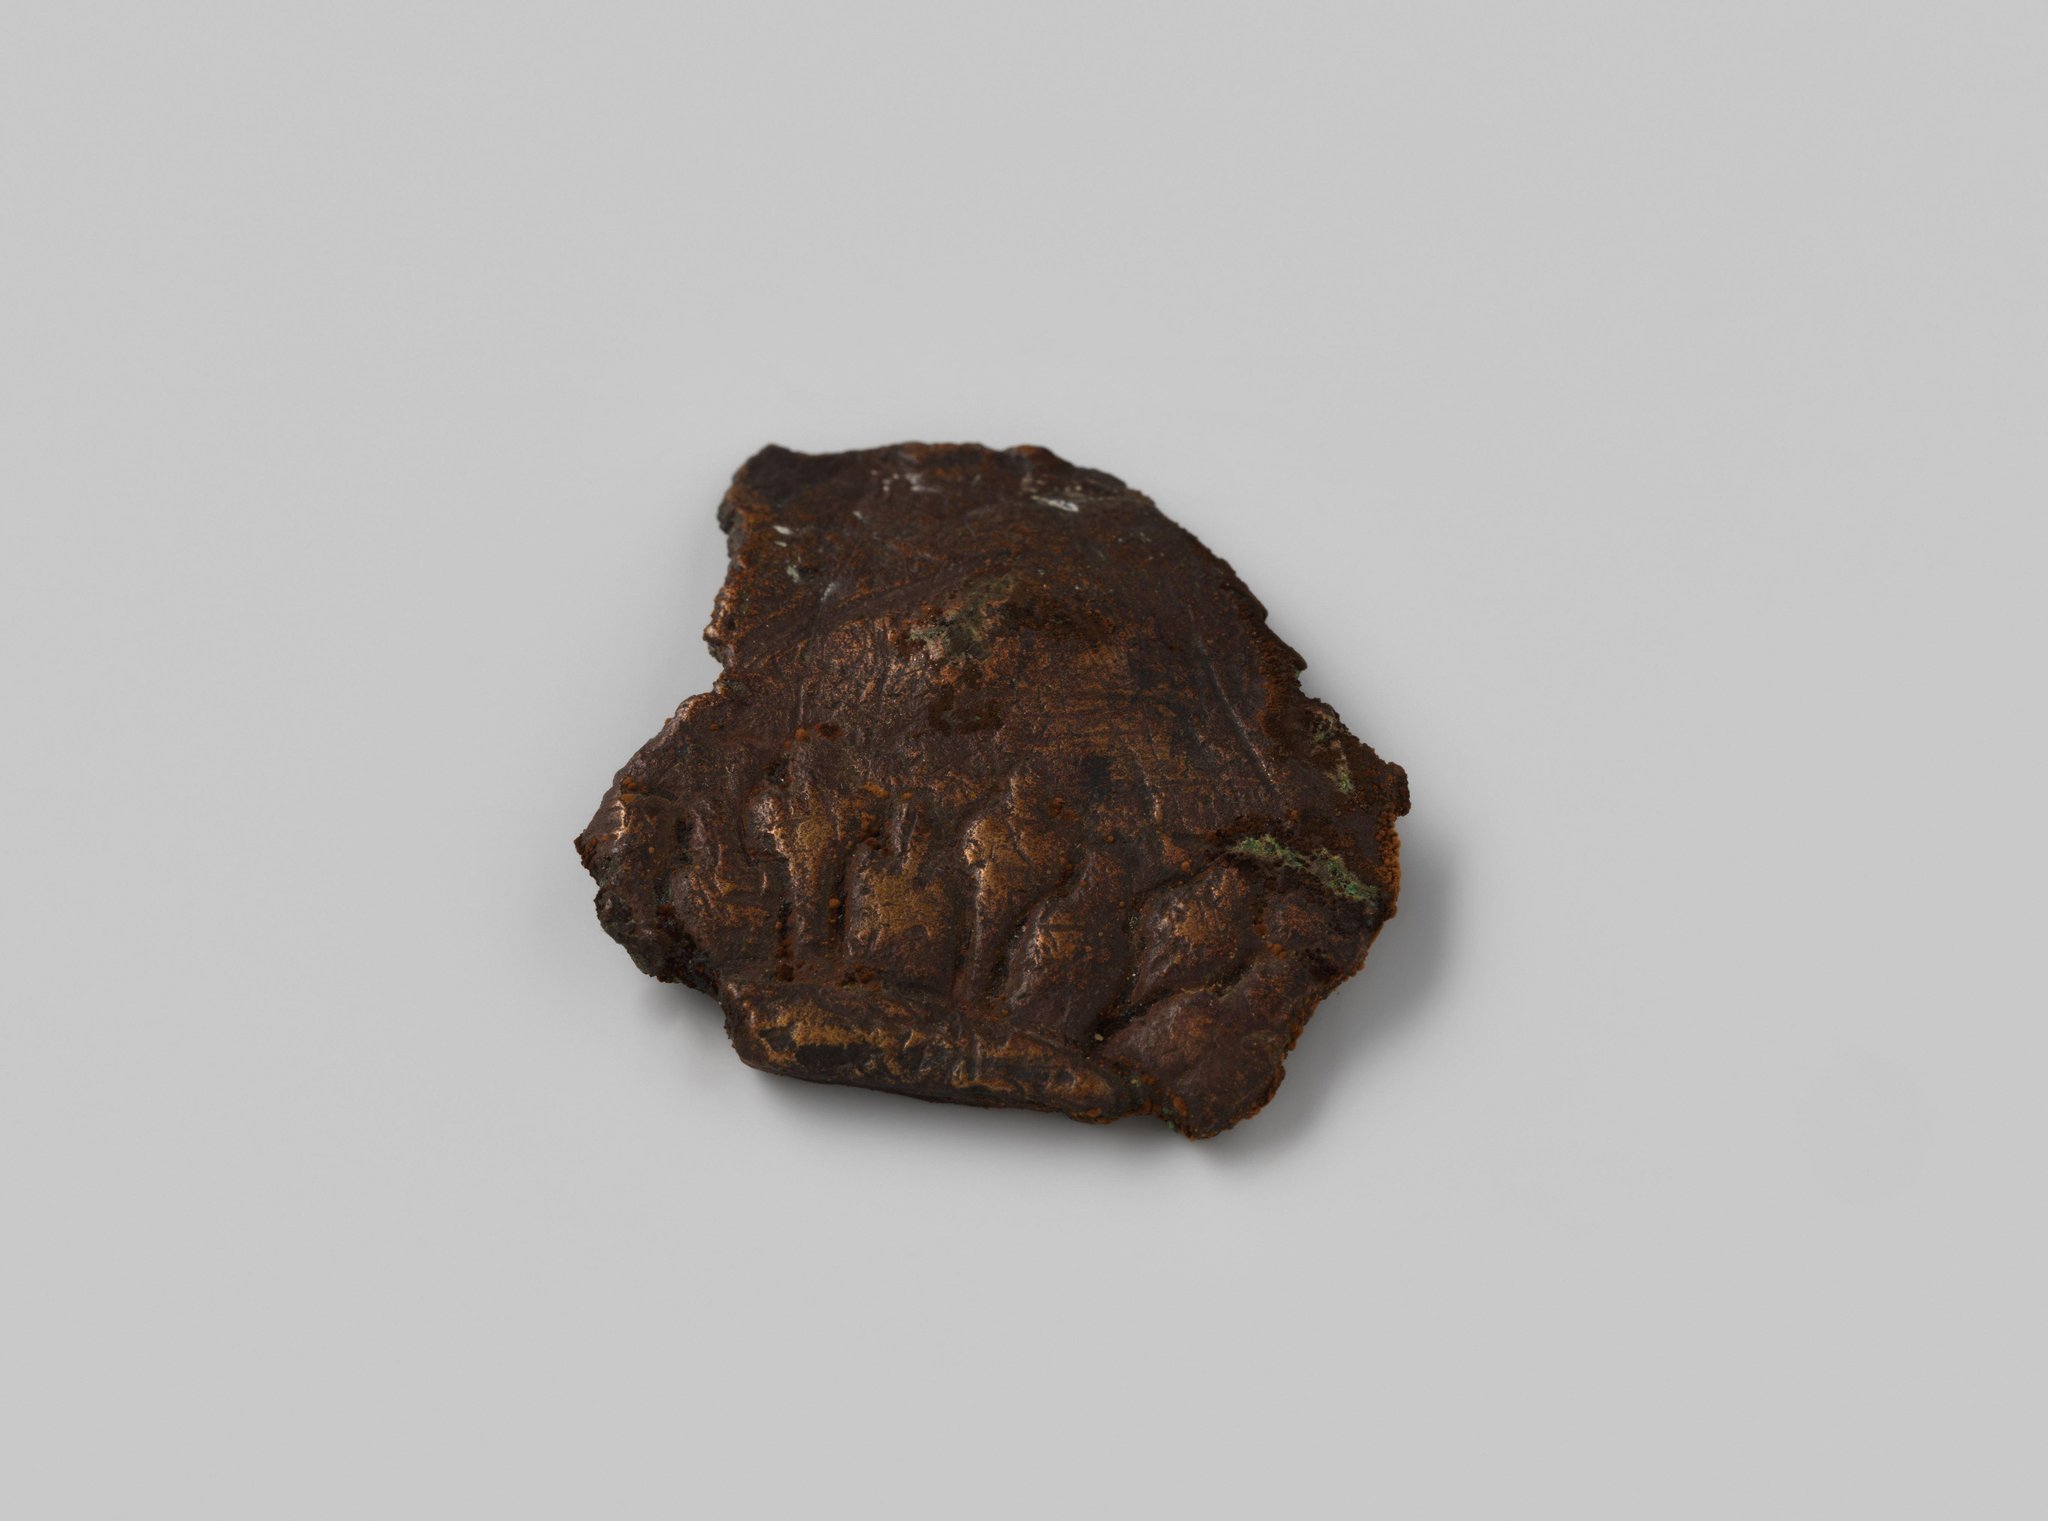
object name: fragment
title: Fragment uit het wrak van de Oost-Indiëvaarder Hollandia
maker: Anonymous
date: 1700-1743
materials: copper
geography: netherlands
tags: verenigde oostindische compagnie, hollandia (schip), annet